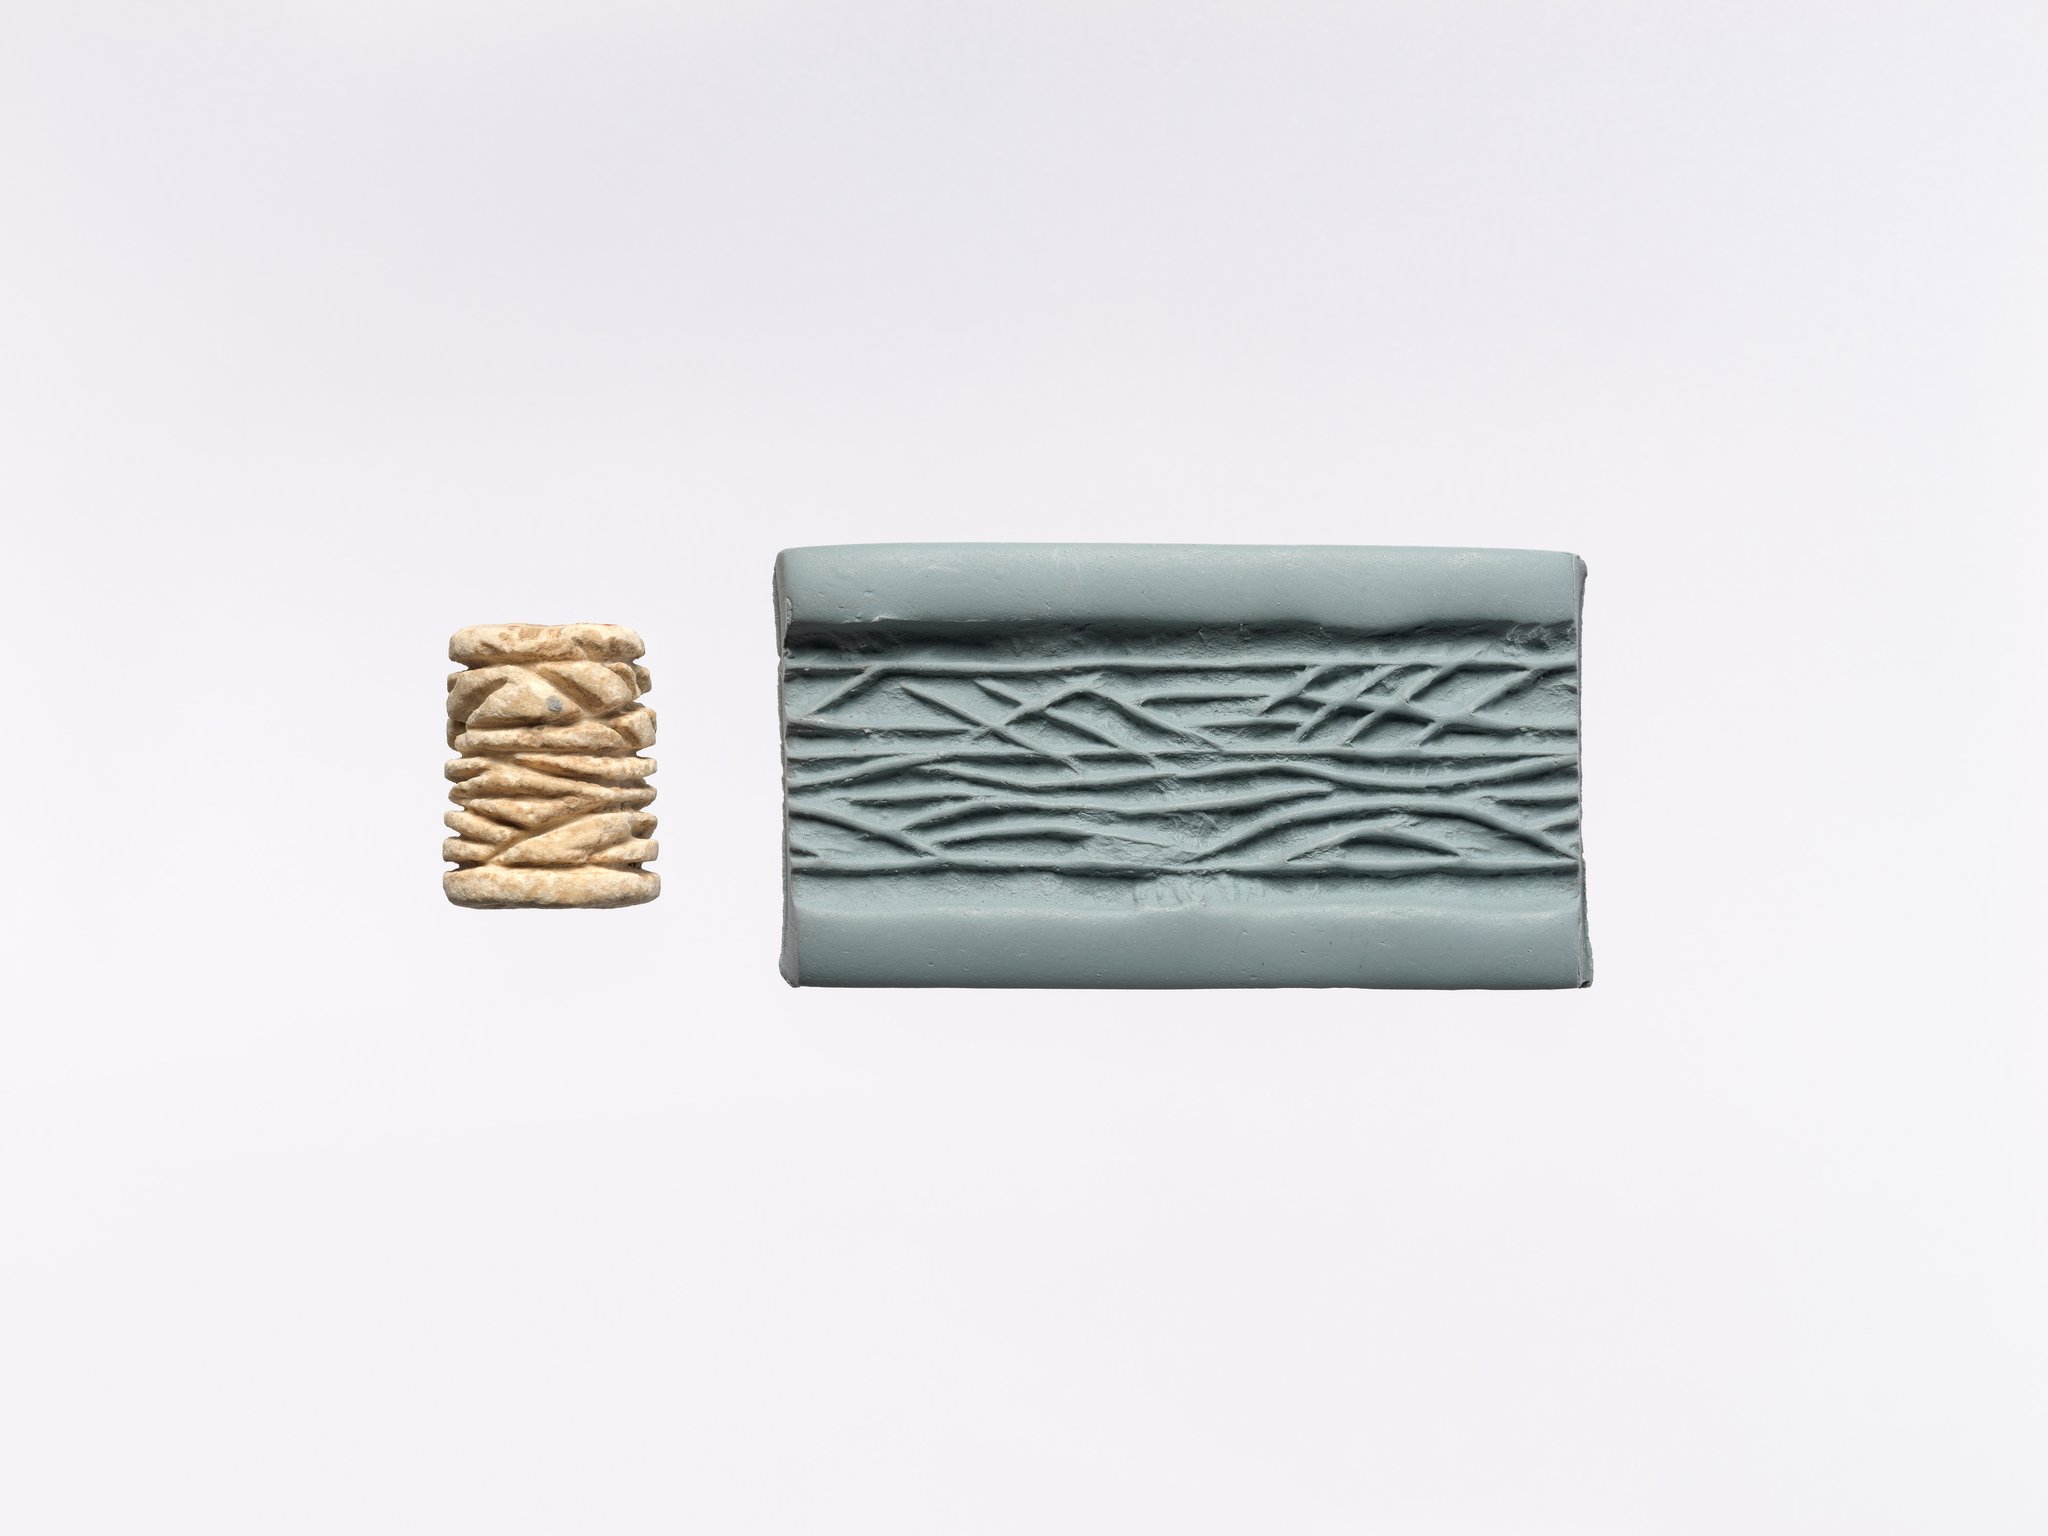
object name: cylinder seal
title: Cylinder seal and modern impression: oblique lines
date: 2600-2500 BCE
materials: stone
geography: mesopotamia